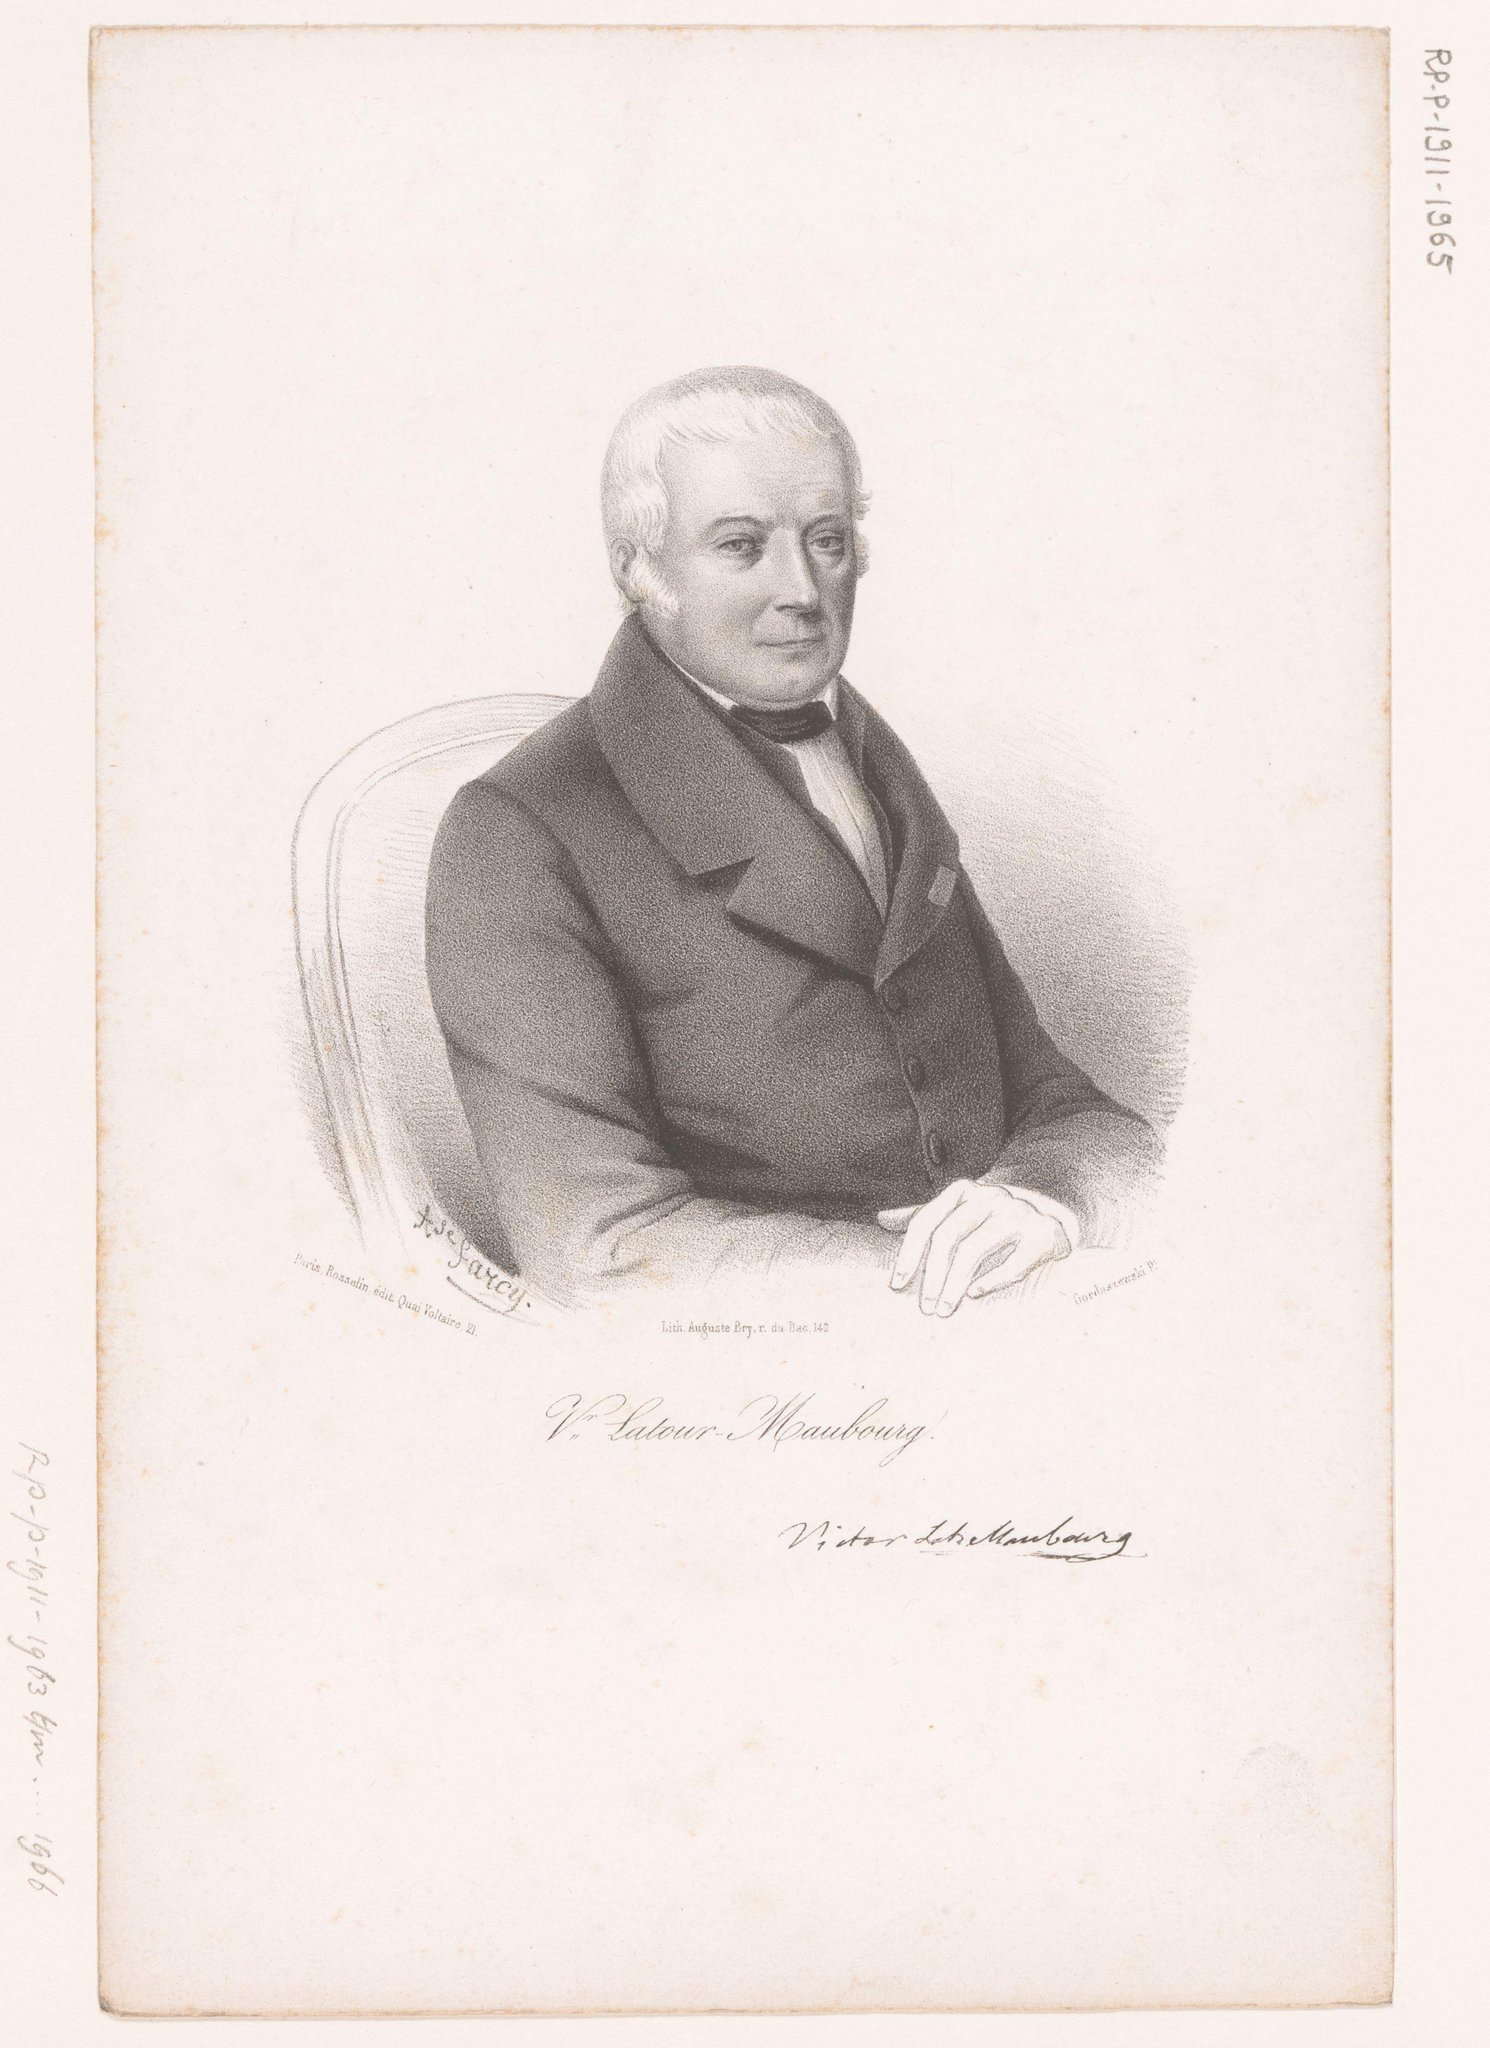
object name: print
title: Portret van Victor de Fay de Latour-Maubourg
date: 1849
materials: paper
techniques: lithograph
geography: paris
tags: historical persons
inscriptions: collector's mark: Lugt 2228a